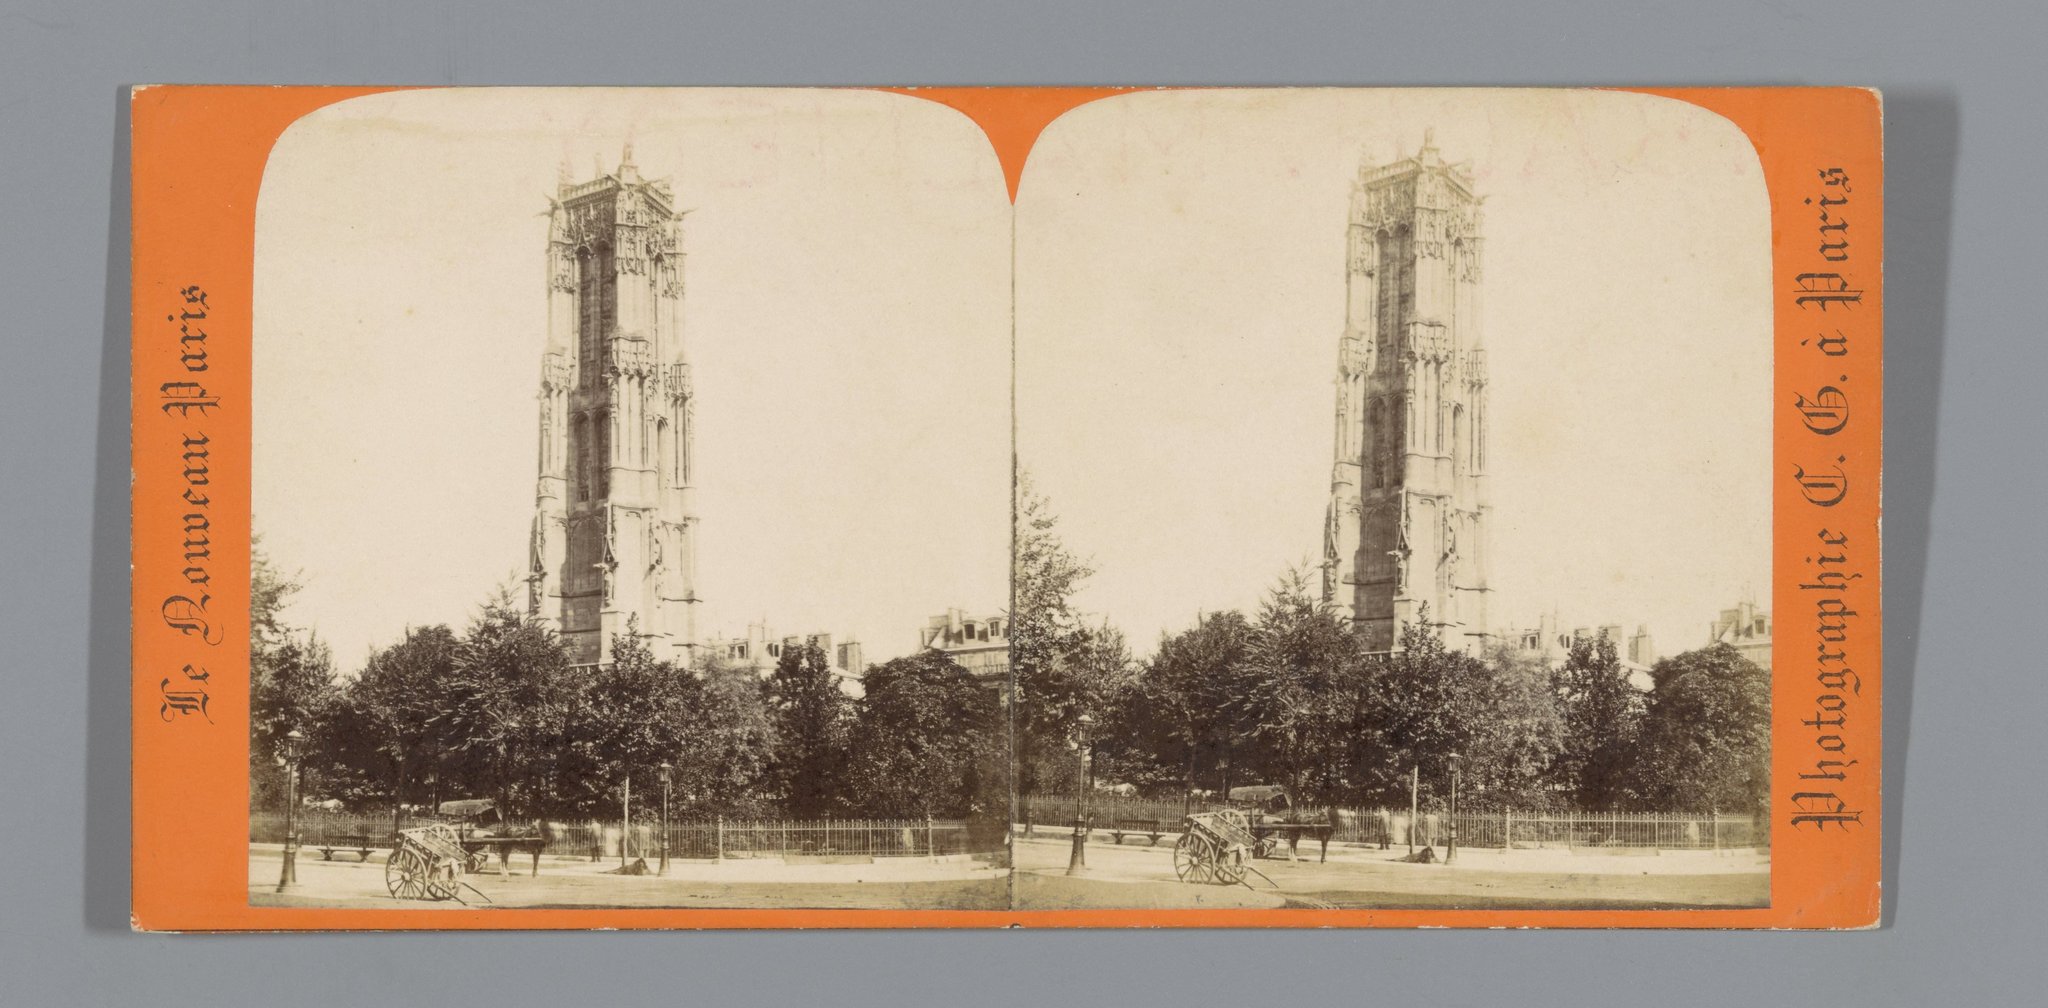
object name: stereograph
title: Le Nouveau Paris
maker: charles gérard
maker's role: fotograaf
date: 1860-1870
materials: cardboard, photographic support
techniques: albumen print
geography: paris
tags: tower, clock tower ~ monumental adornment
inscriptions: inscription: ‘Tour St Jacques’, inscription: ‘Photographie C. G. à Paris.’